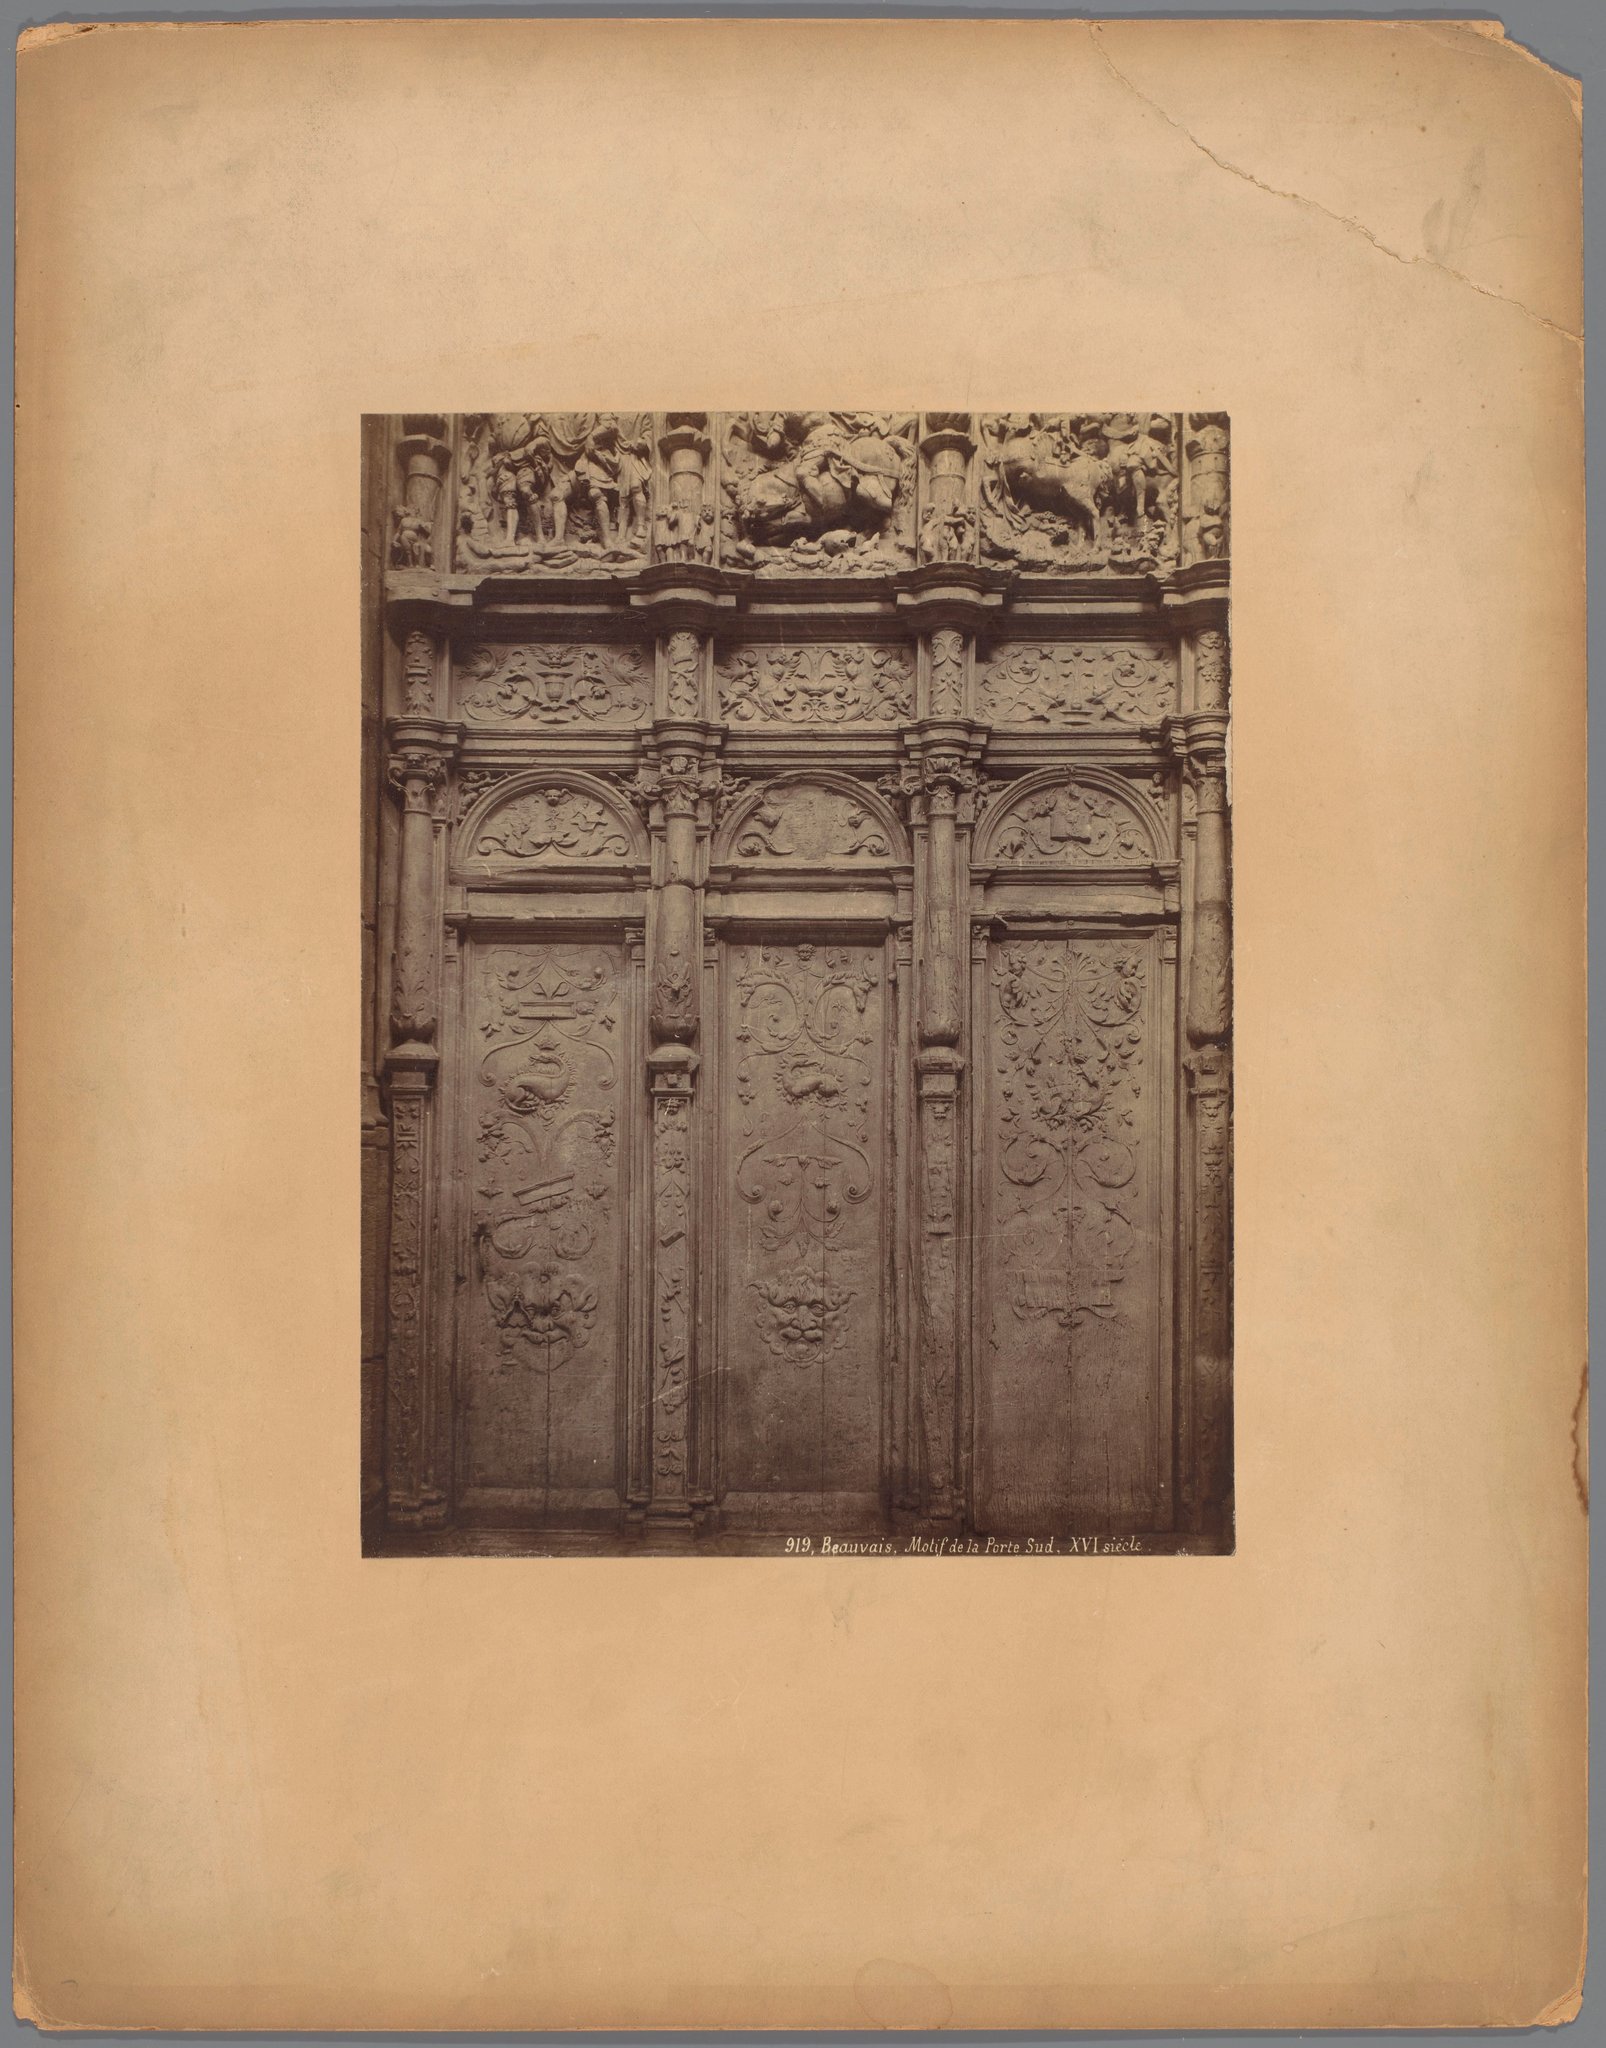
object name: photograph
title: Beauvais, Motif de la Porte Sud, XVI siècle.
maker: Anonymous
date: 1875-1900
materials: cardboard, photographic support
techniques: albumen print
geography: beauvais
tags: parts of church exterior and annexes: portal, sculpture (+ relief ~ sculpture)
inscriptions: number: ‘919.’, collector's mark: Lugt 3937